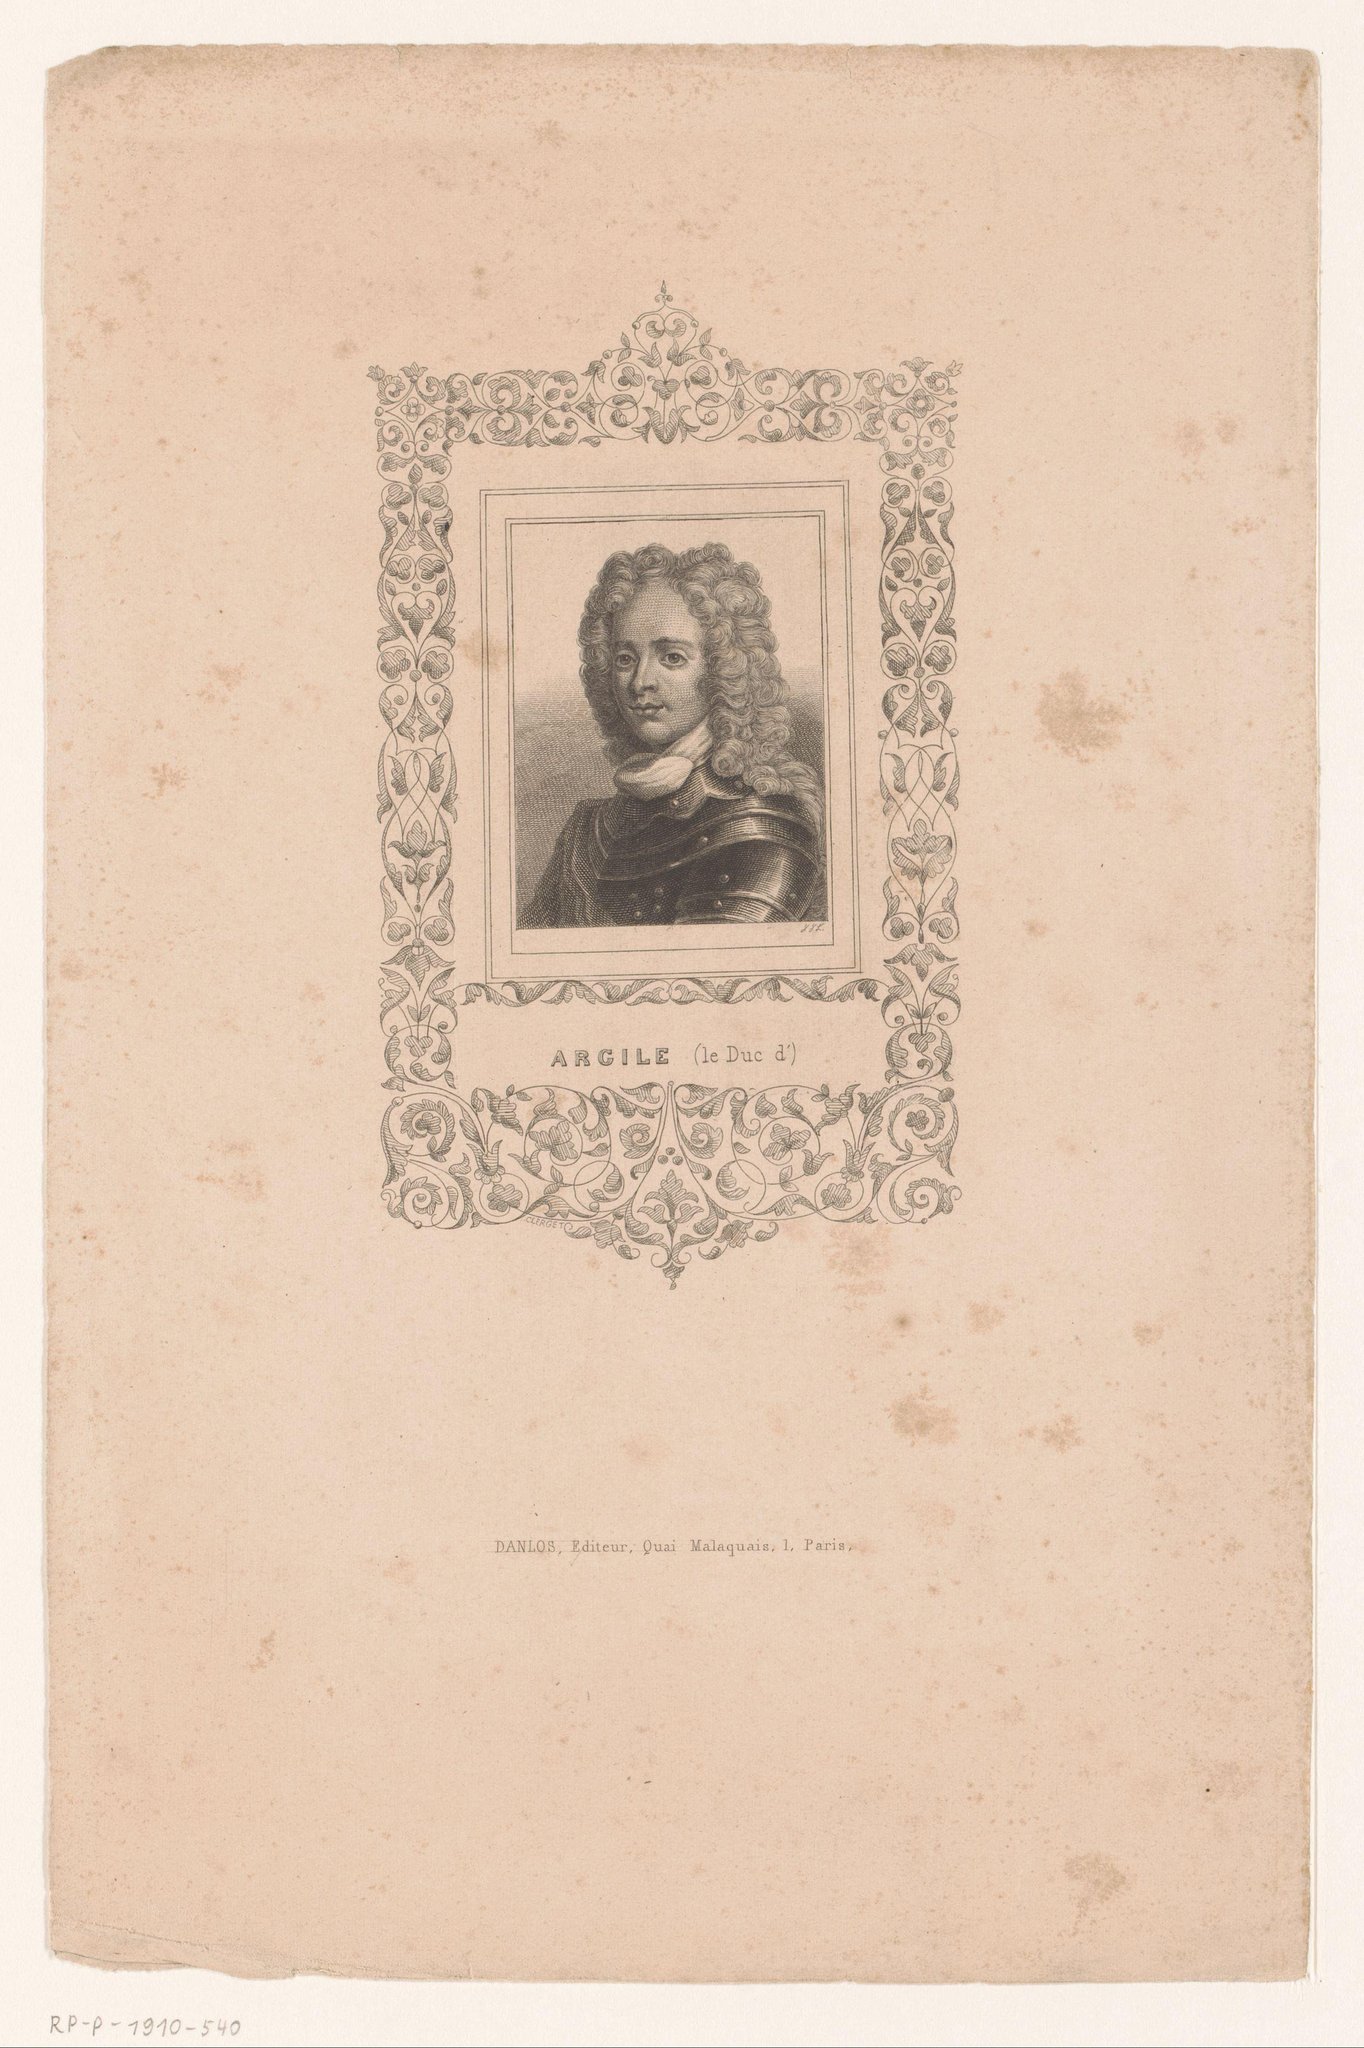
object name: print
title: Portret van de hertog van Argyll, mogelijk John Campbell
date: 1828-1870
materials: paper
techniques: engraving, etching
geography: paris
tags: historical persons, nobility and patriciate; chivalry, knighthood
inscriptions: collector's mark: Lugt 2228